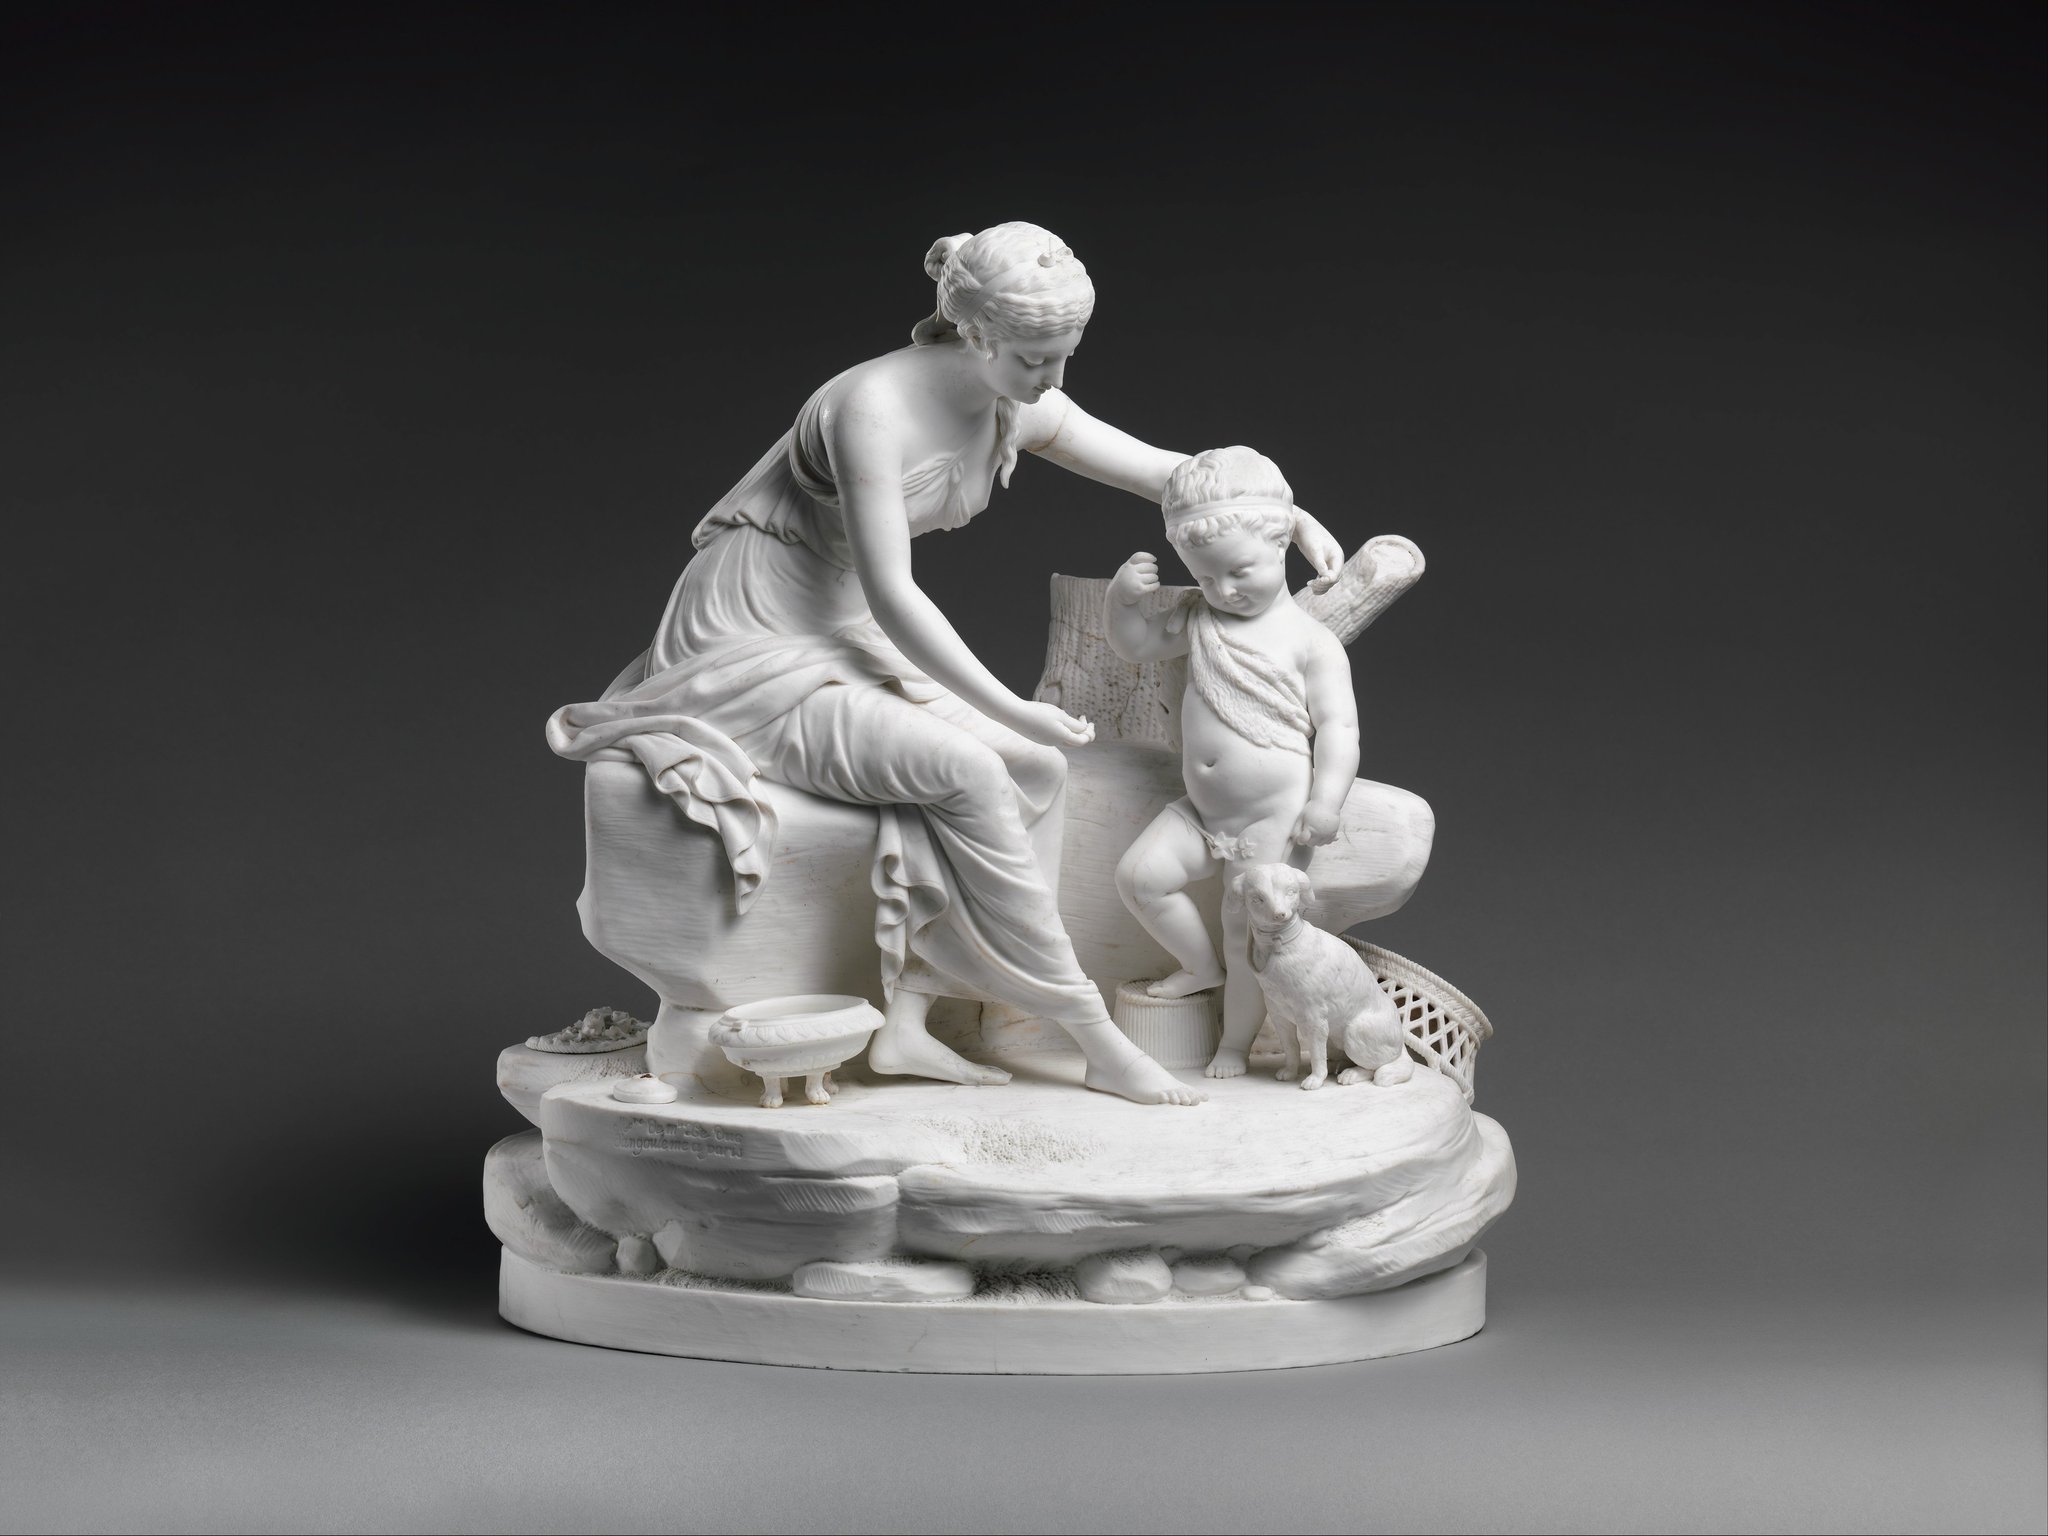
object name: figure group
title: Seated woman and the infant Hercules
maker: dihl et guérhard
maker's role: factory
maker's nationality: french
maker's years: 1781-1824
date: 1781-1789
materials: biscuit, paste, porcelain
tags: musical instruments,infants,women,hercules,dogs,baskets,lyres